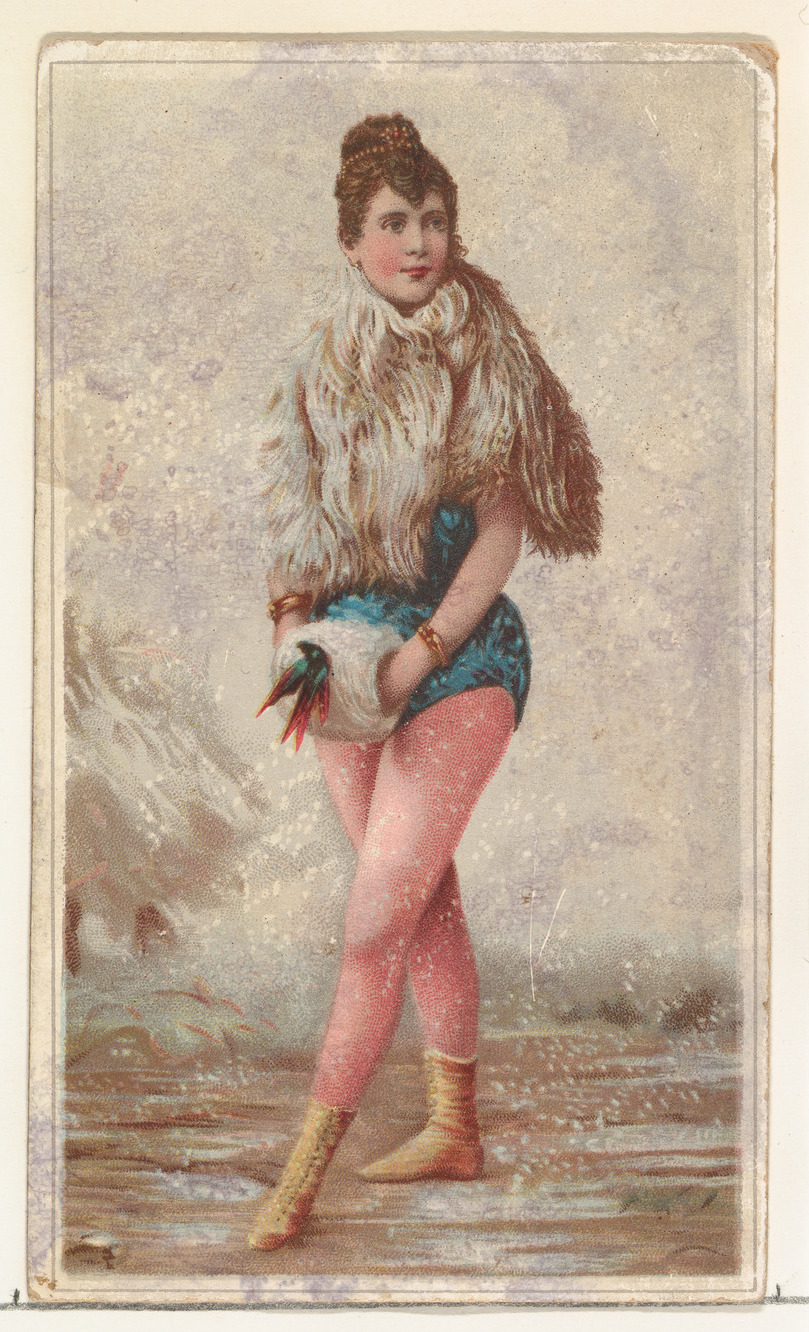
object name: print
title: Actress wearing fur coat and muff, from Stars of the Stage, Second Series (N130) issued by Duke Sons & Co. to promote Honest Long Cut Tobacco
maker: w. duke, sons & co.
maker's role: publisher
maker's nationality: american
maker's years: 1870-1920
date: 1891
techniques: color lithograph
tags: portraits,women,actors